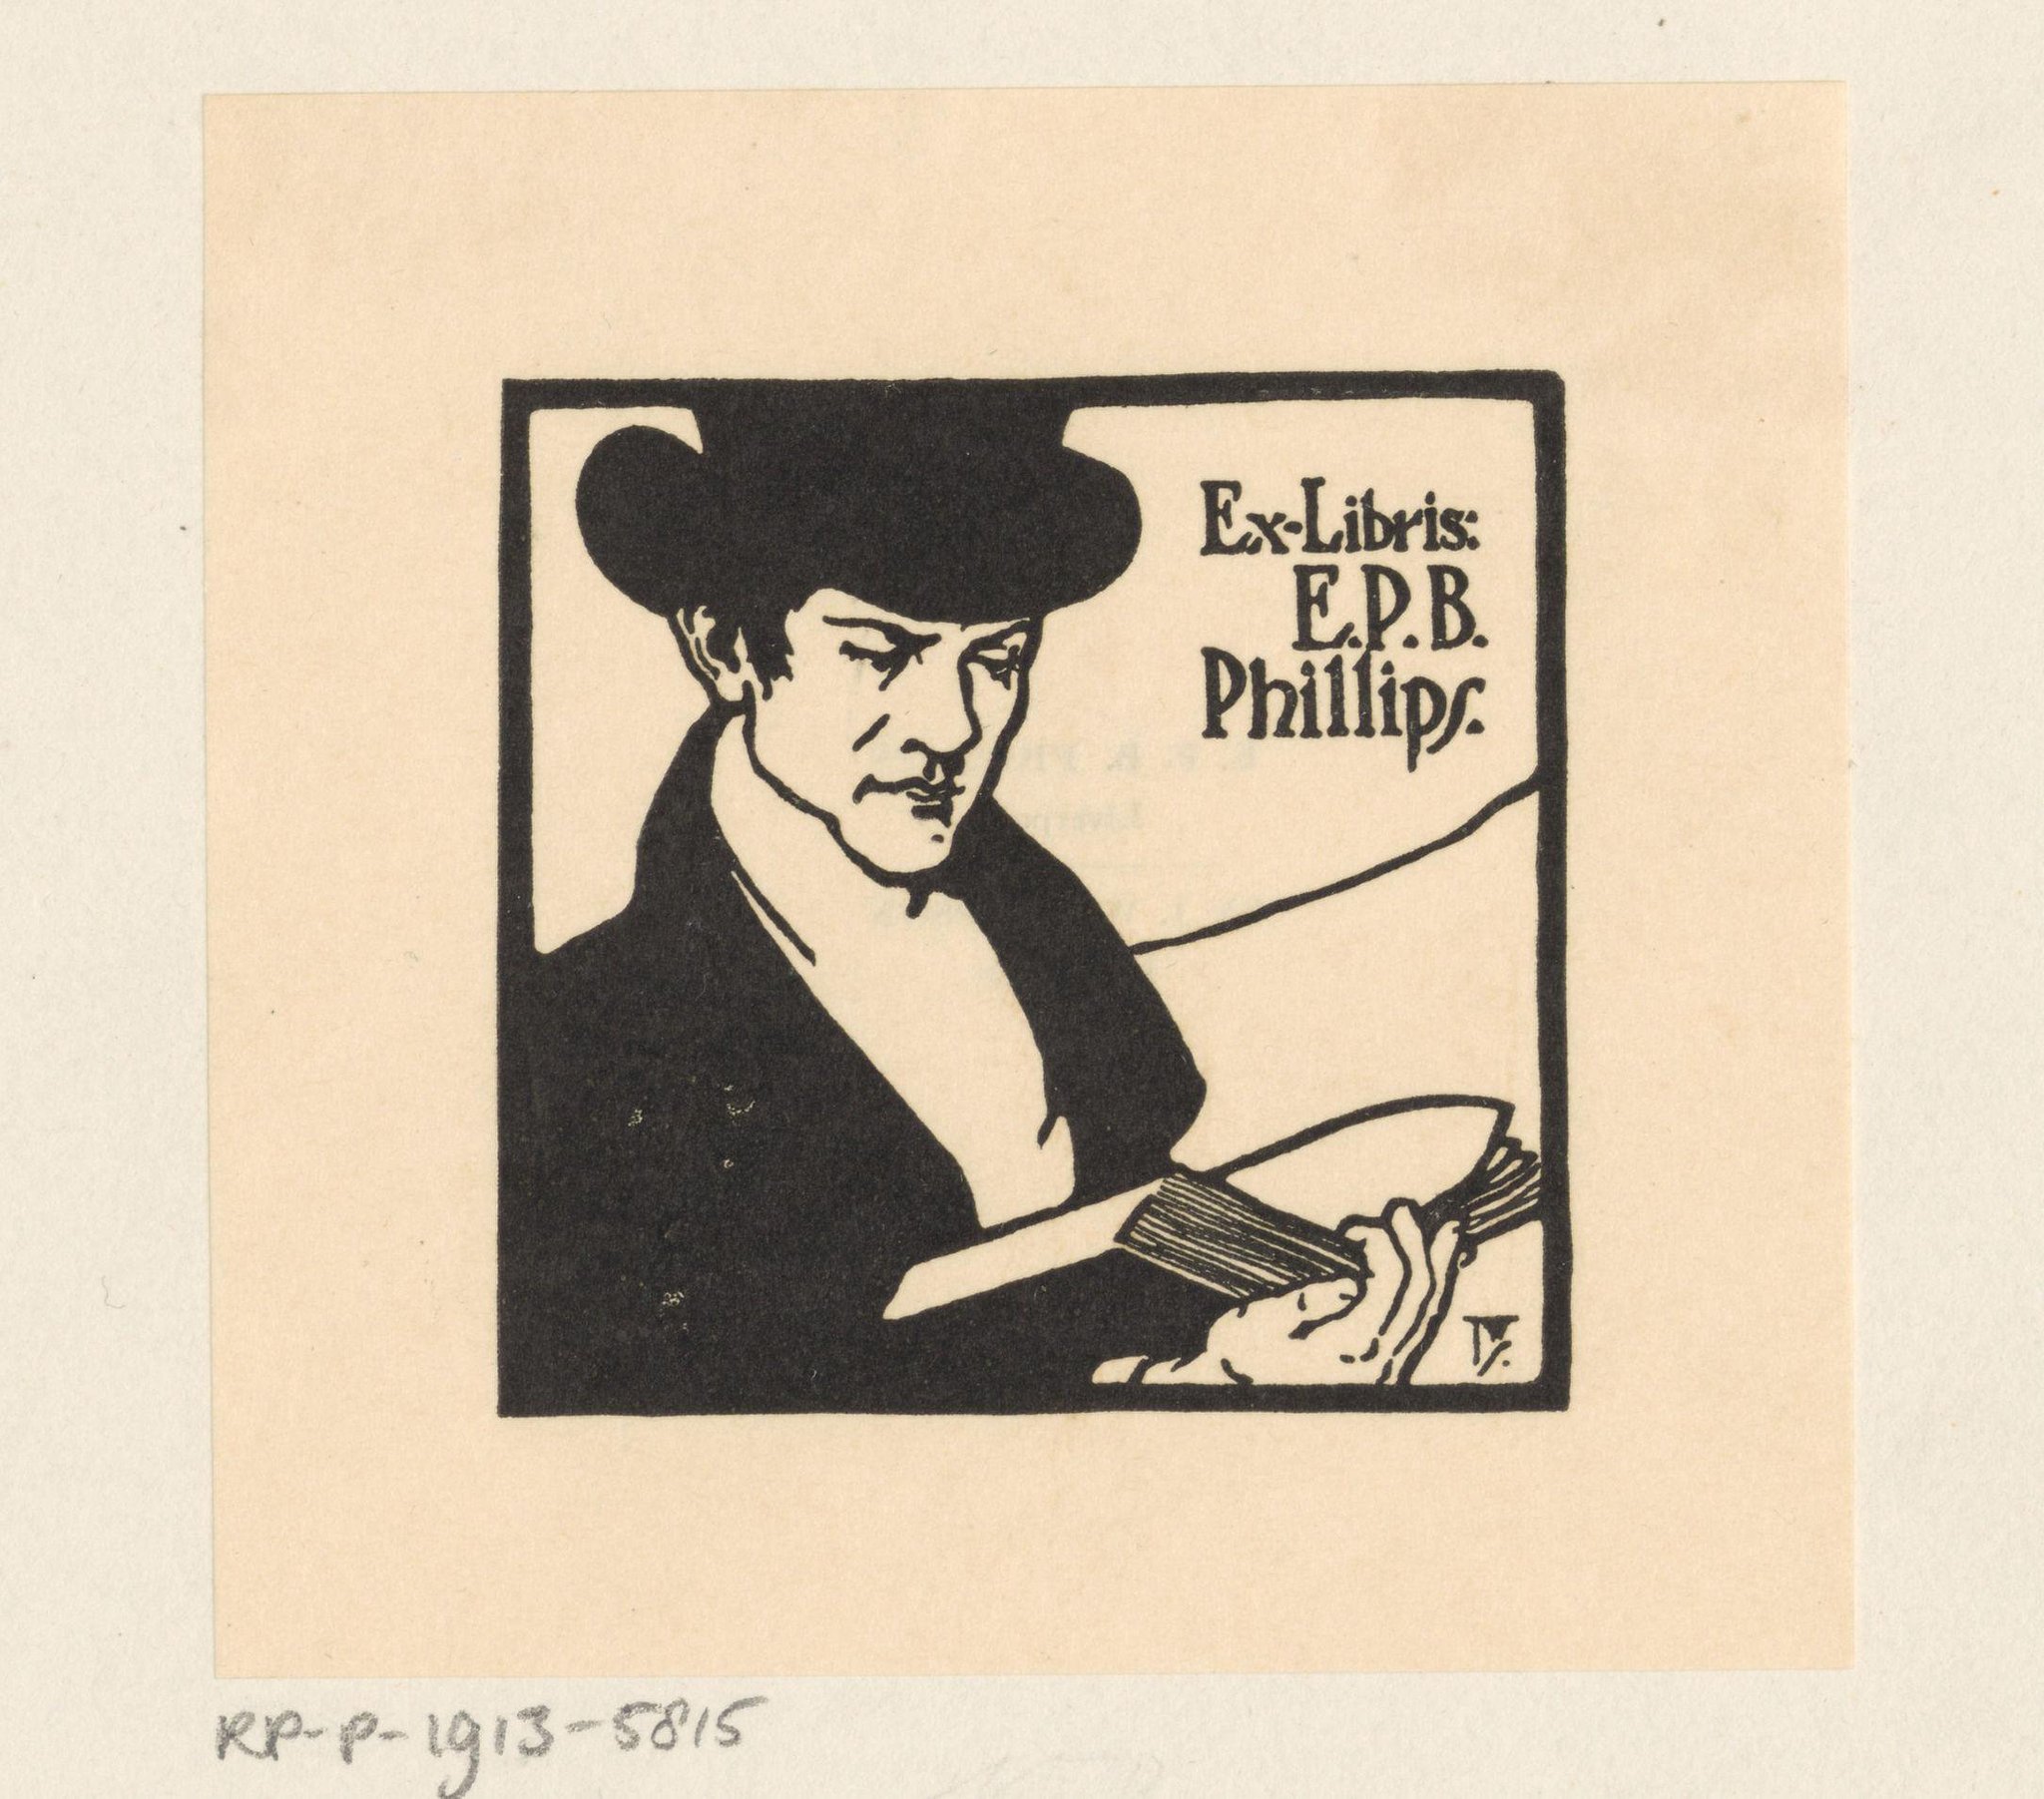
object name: bookplate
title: Ex libris van E.P.B. Phillips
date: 1889-1913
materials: paper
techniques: printing block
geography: england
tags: reading, adult man, head-gear: top hat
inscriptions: collector's mark: Lugt 2233, inscription: ‘E.P.B. Phillips / Liverpool / by J.W. Simpson / Edinburgh’, collector's mark: Lugt 2760